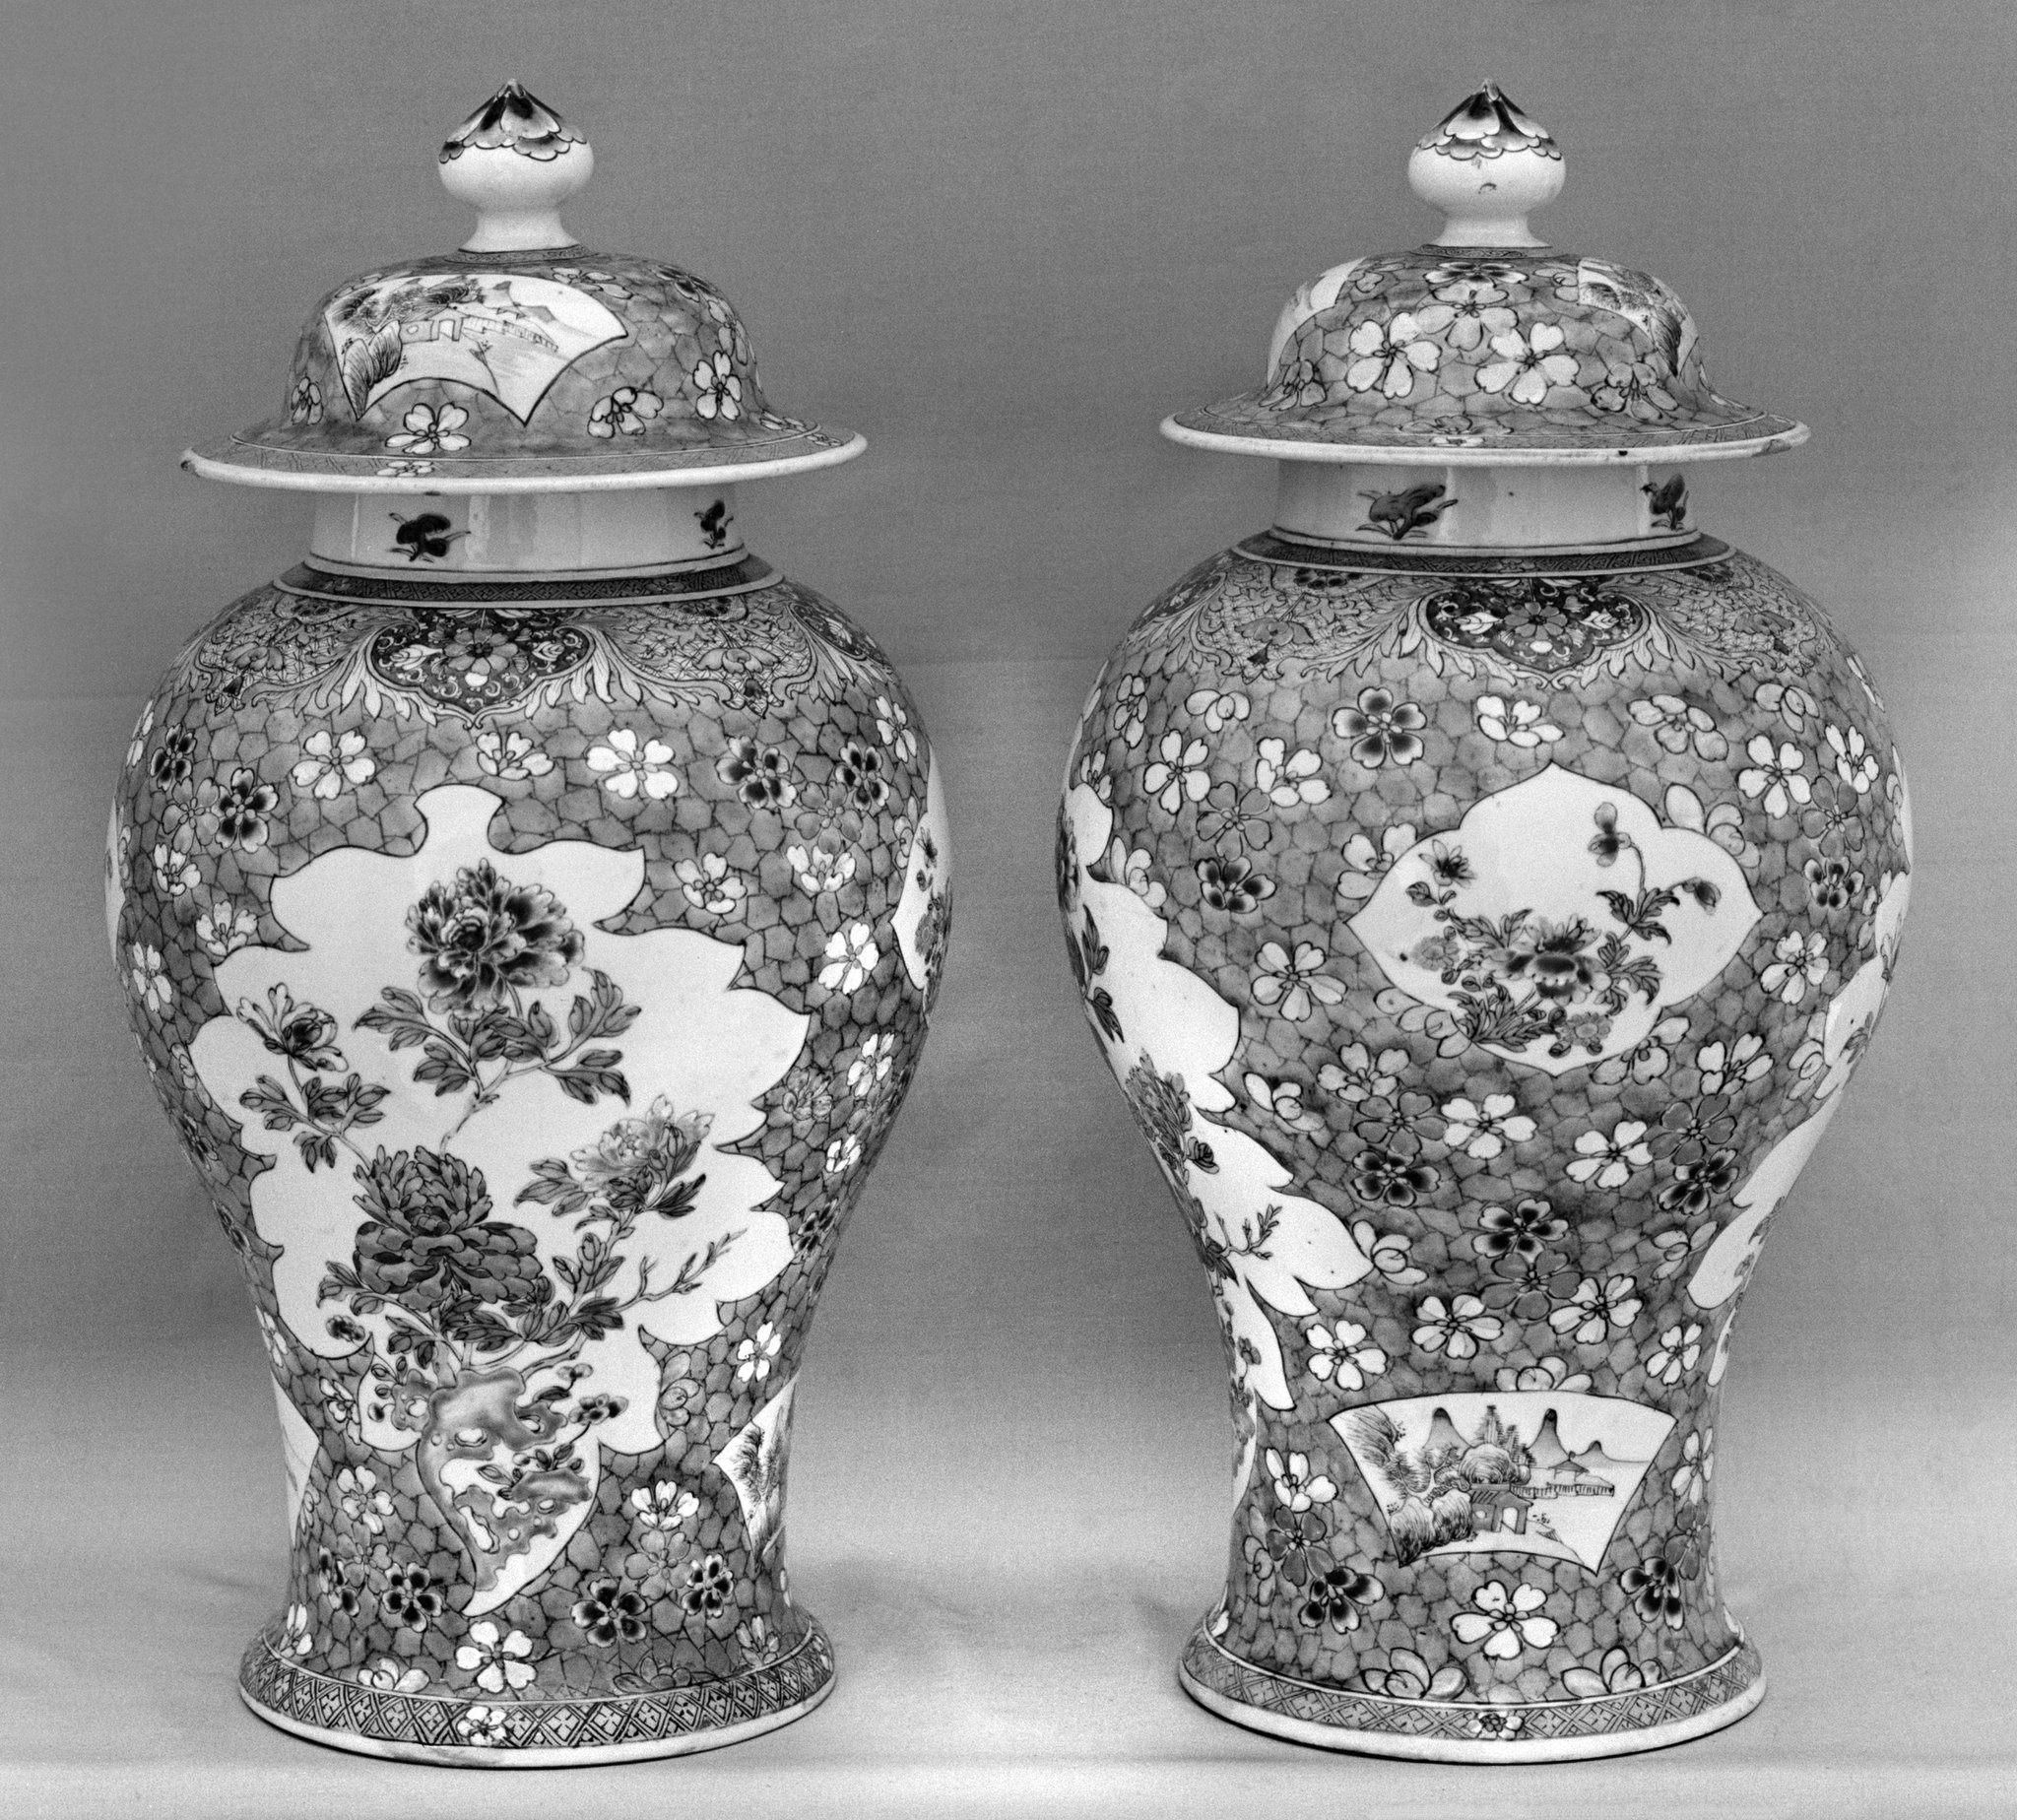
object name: jar with cover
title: Jar with Cover (one of a pair)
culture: chinese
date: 1736-1795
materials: porcelain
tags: flowers,landscapes,leaves